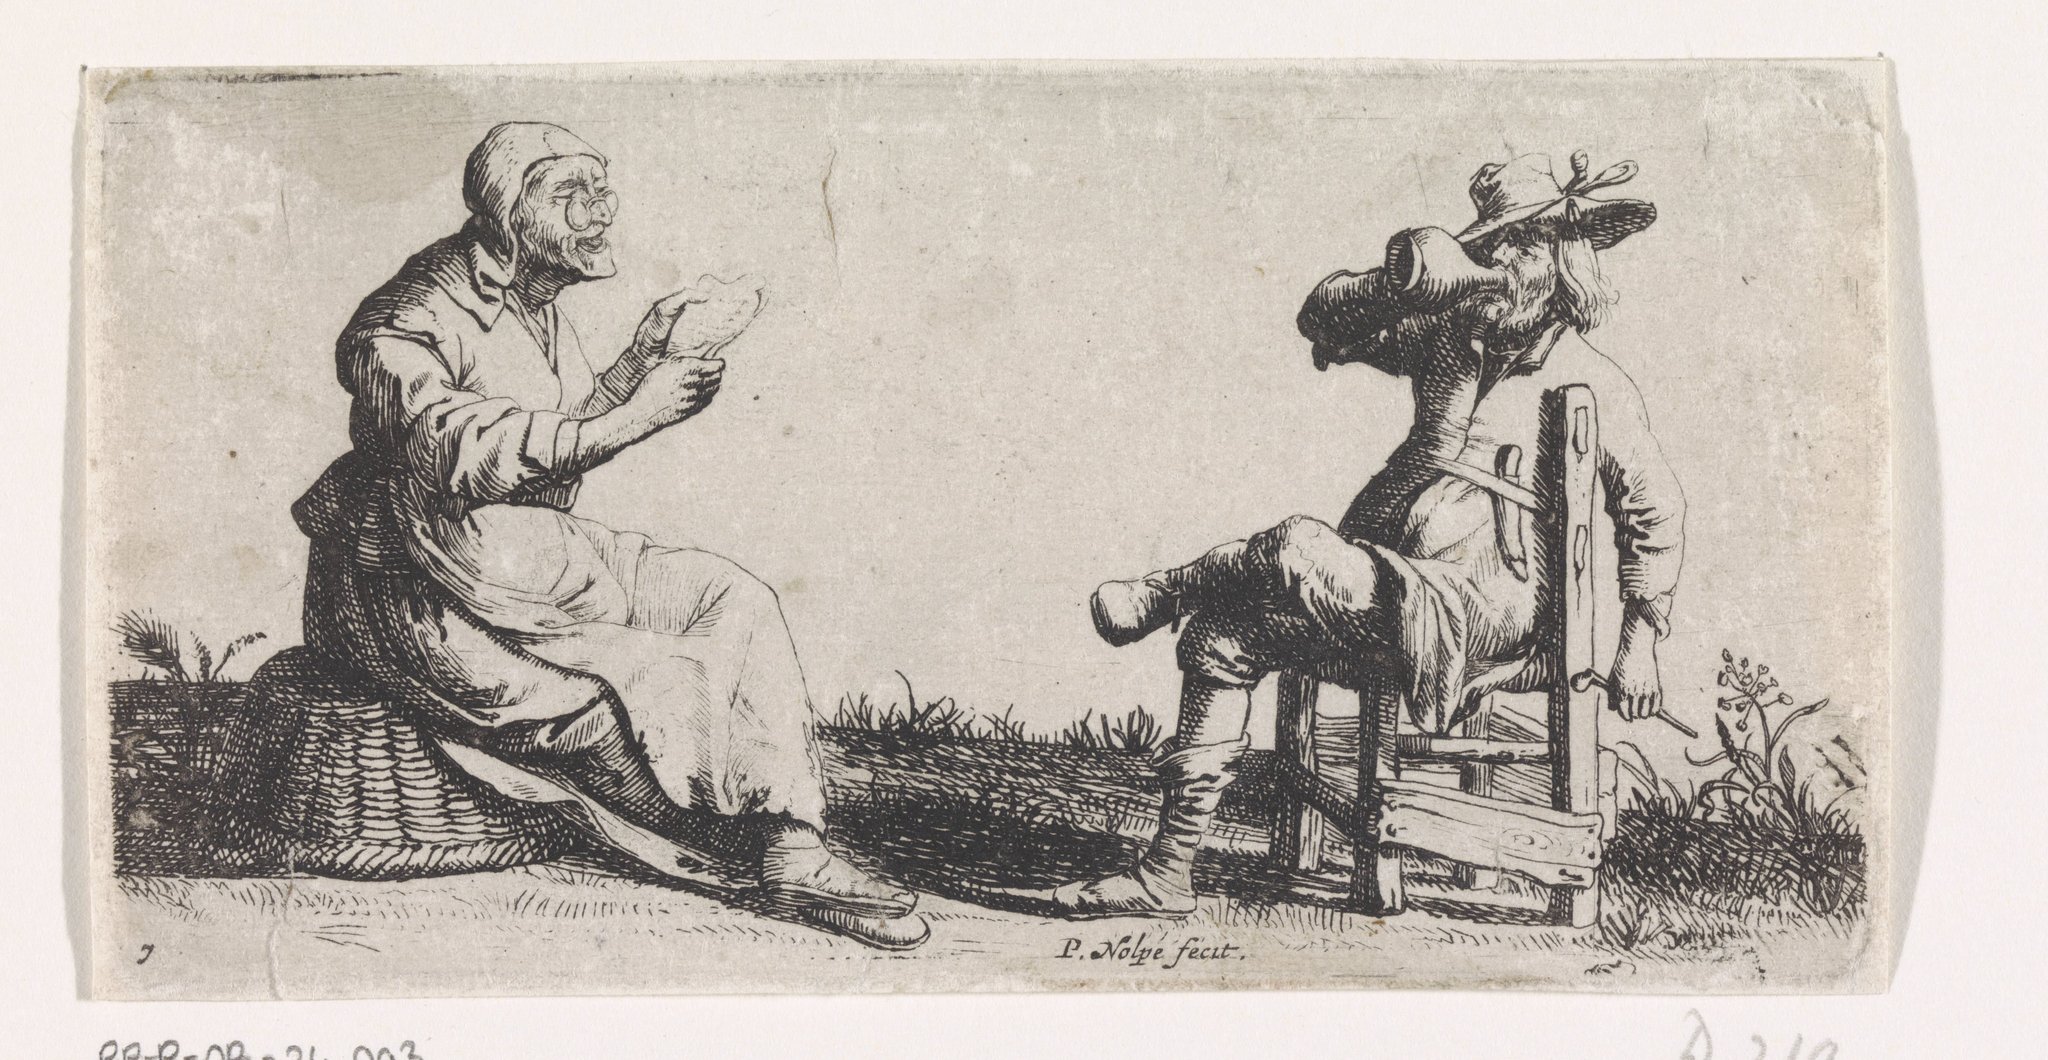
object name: print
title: Scènes uit het boerenleven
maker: pieter nolpe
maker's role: draughtsman, print maker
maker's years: 1613-1653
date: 1623-1653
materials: paper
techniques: engraving, etching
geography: amsterdam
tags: pipe ~ tobacco, jar, jug (used as drinking-vessel), farmers, reading to somebody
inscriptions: collector's mark: Lugt 2228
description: Een boerin zit op een omgekeerde mand en leest met een bril op haar neus van het papier wat ze in haar handen houdt. Tegenover haar zit een boer op een stoel met een pijp in de hand. Hij zet een kruik aan zijn mond. Prent maakt deel uit van een serie met scènes uit het boerenleven.